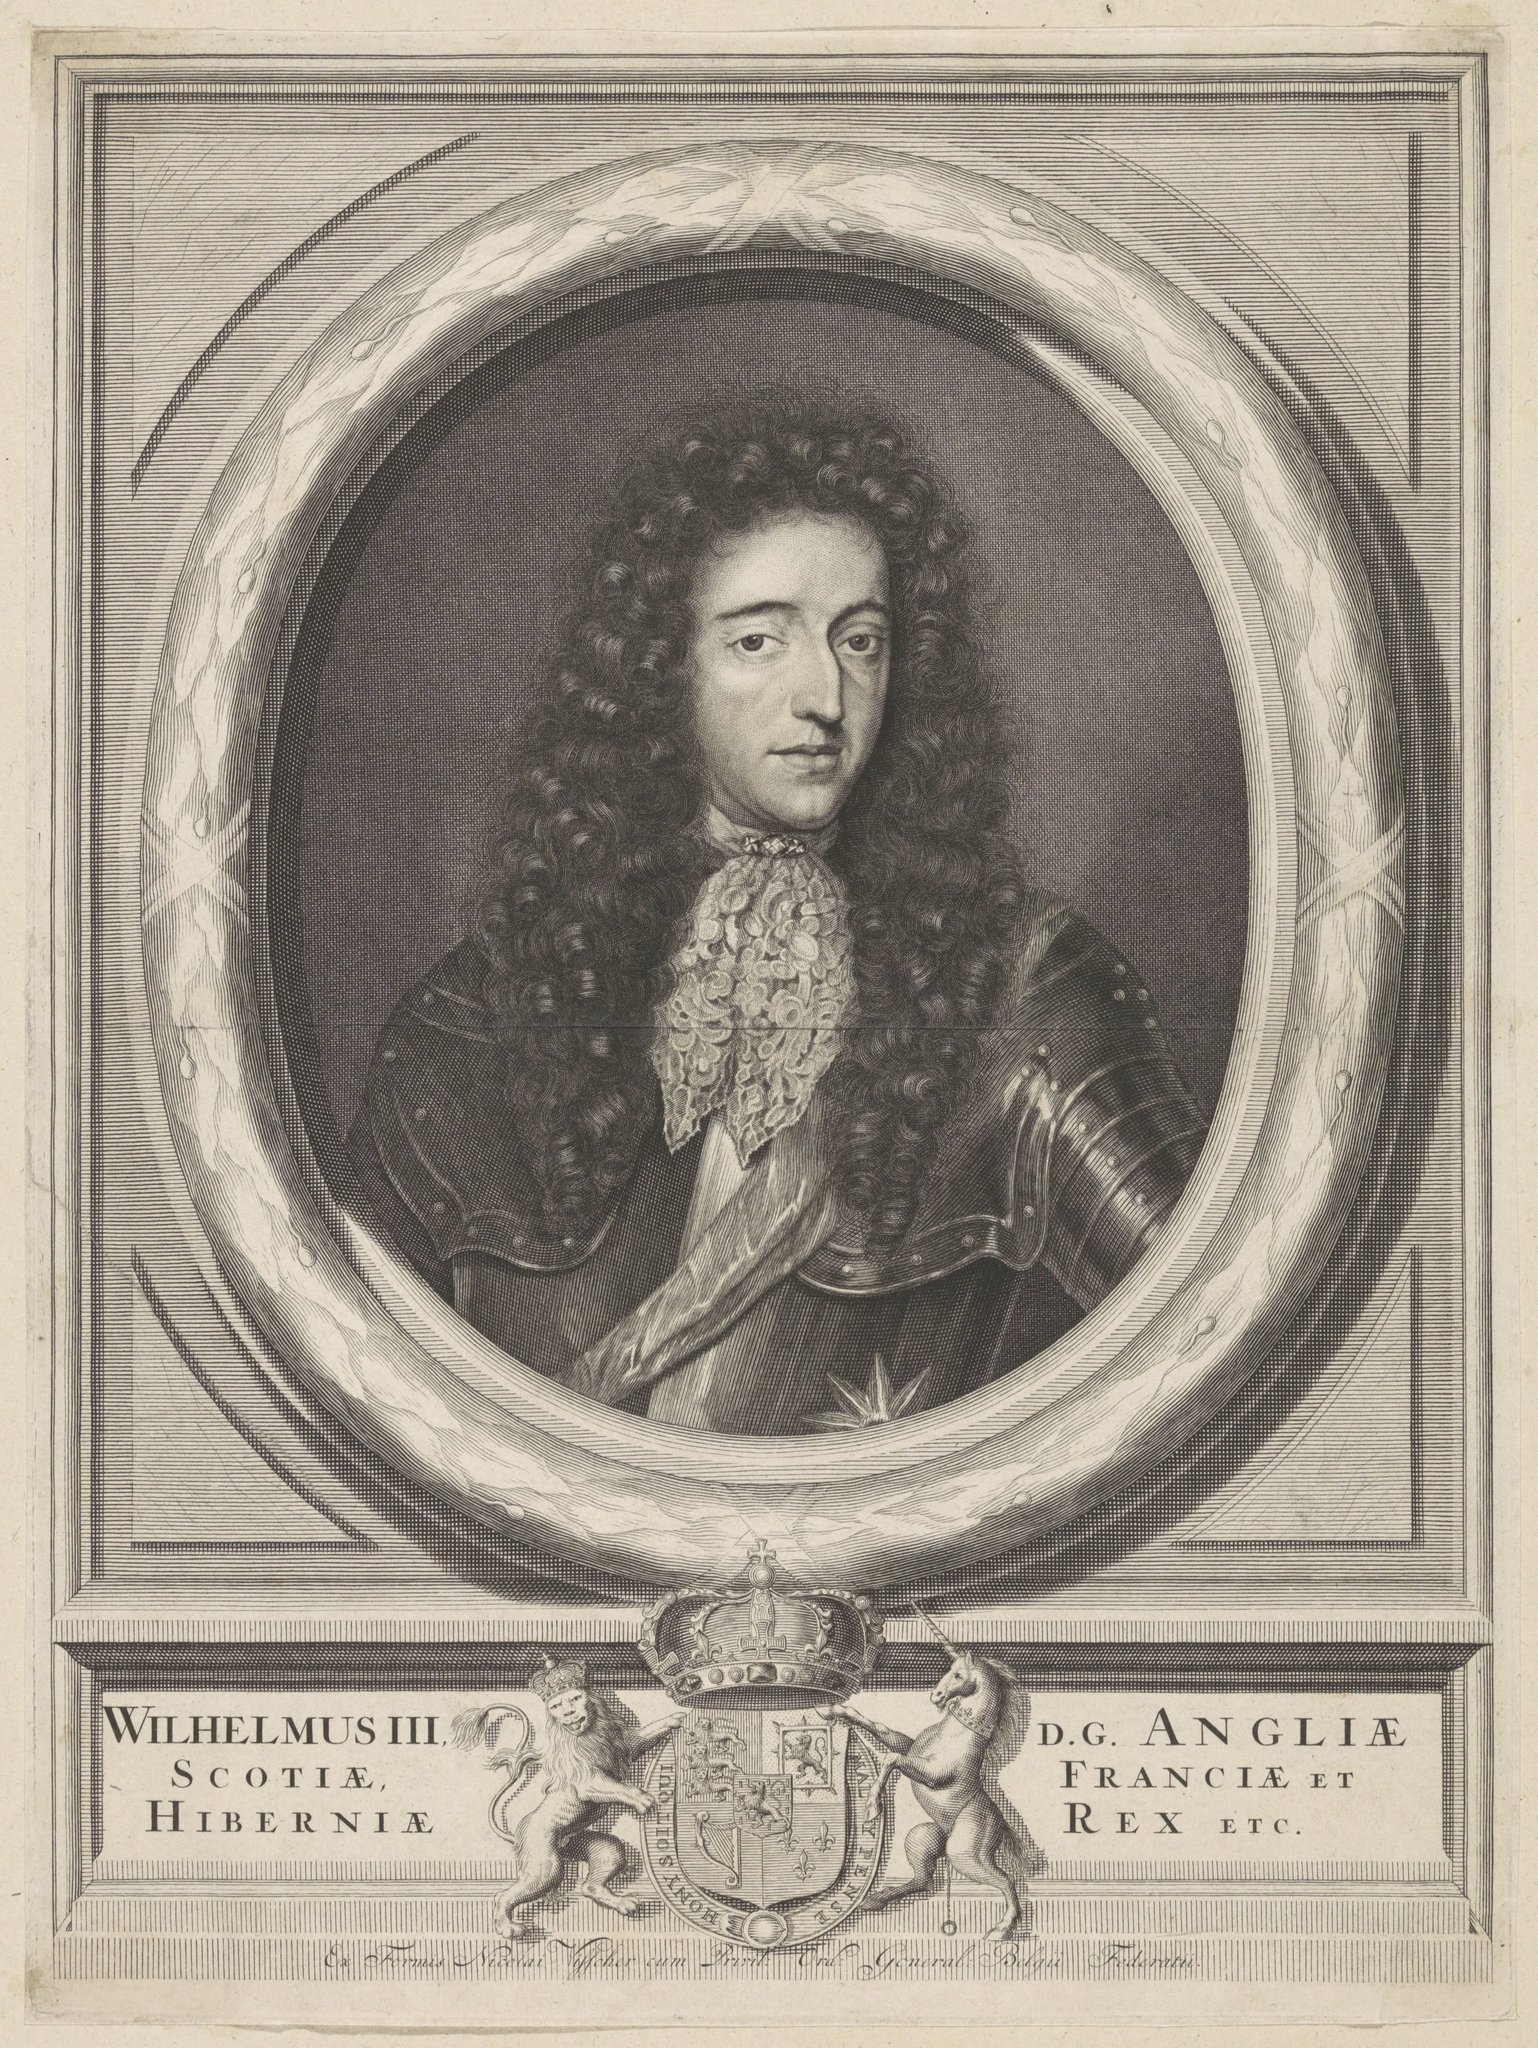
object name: manuscript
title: Portret van Willem III, prins van Oranje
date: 1688-1702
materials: paper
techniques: engraving, etching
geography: amsterdam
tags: the hague, william iii (prince of orange and king of england, scotland, and ireland), knighthood order (garter) - insignia of a knighthood order, e.g.: badge, chain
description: Portret van Willem III in een ovaal van eikenloof. Midden onder zijn wapen met een kroon, een leeuw en een eenhoorn, gedecoreerd met de Kousenband en het devies van de Orde van de Kousenband. Op een voetstuk zijn naam en titels. Daaronder losse opgeplakte handtekening met pen.